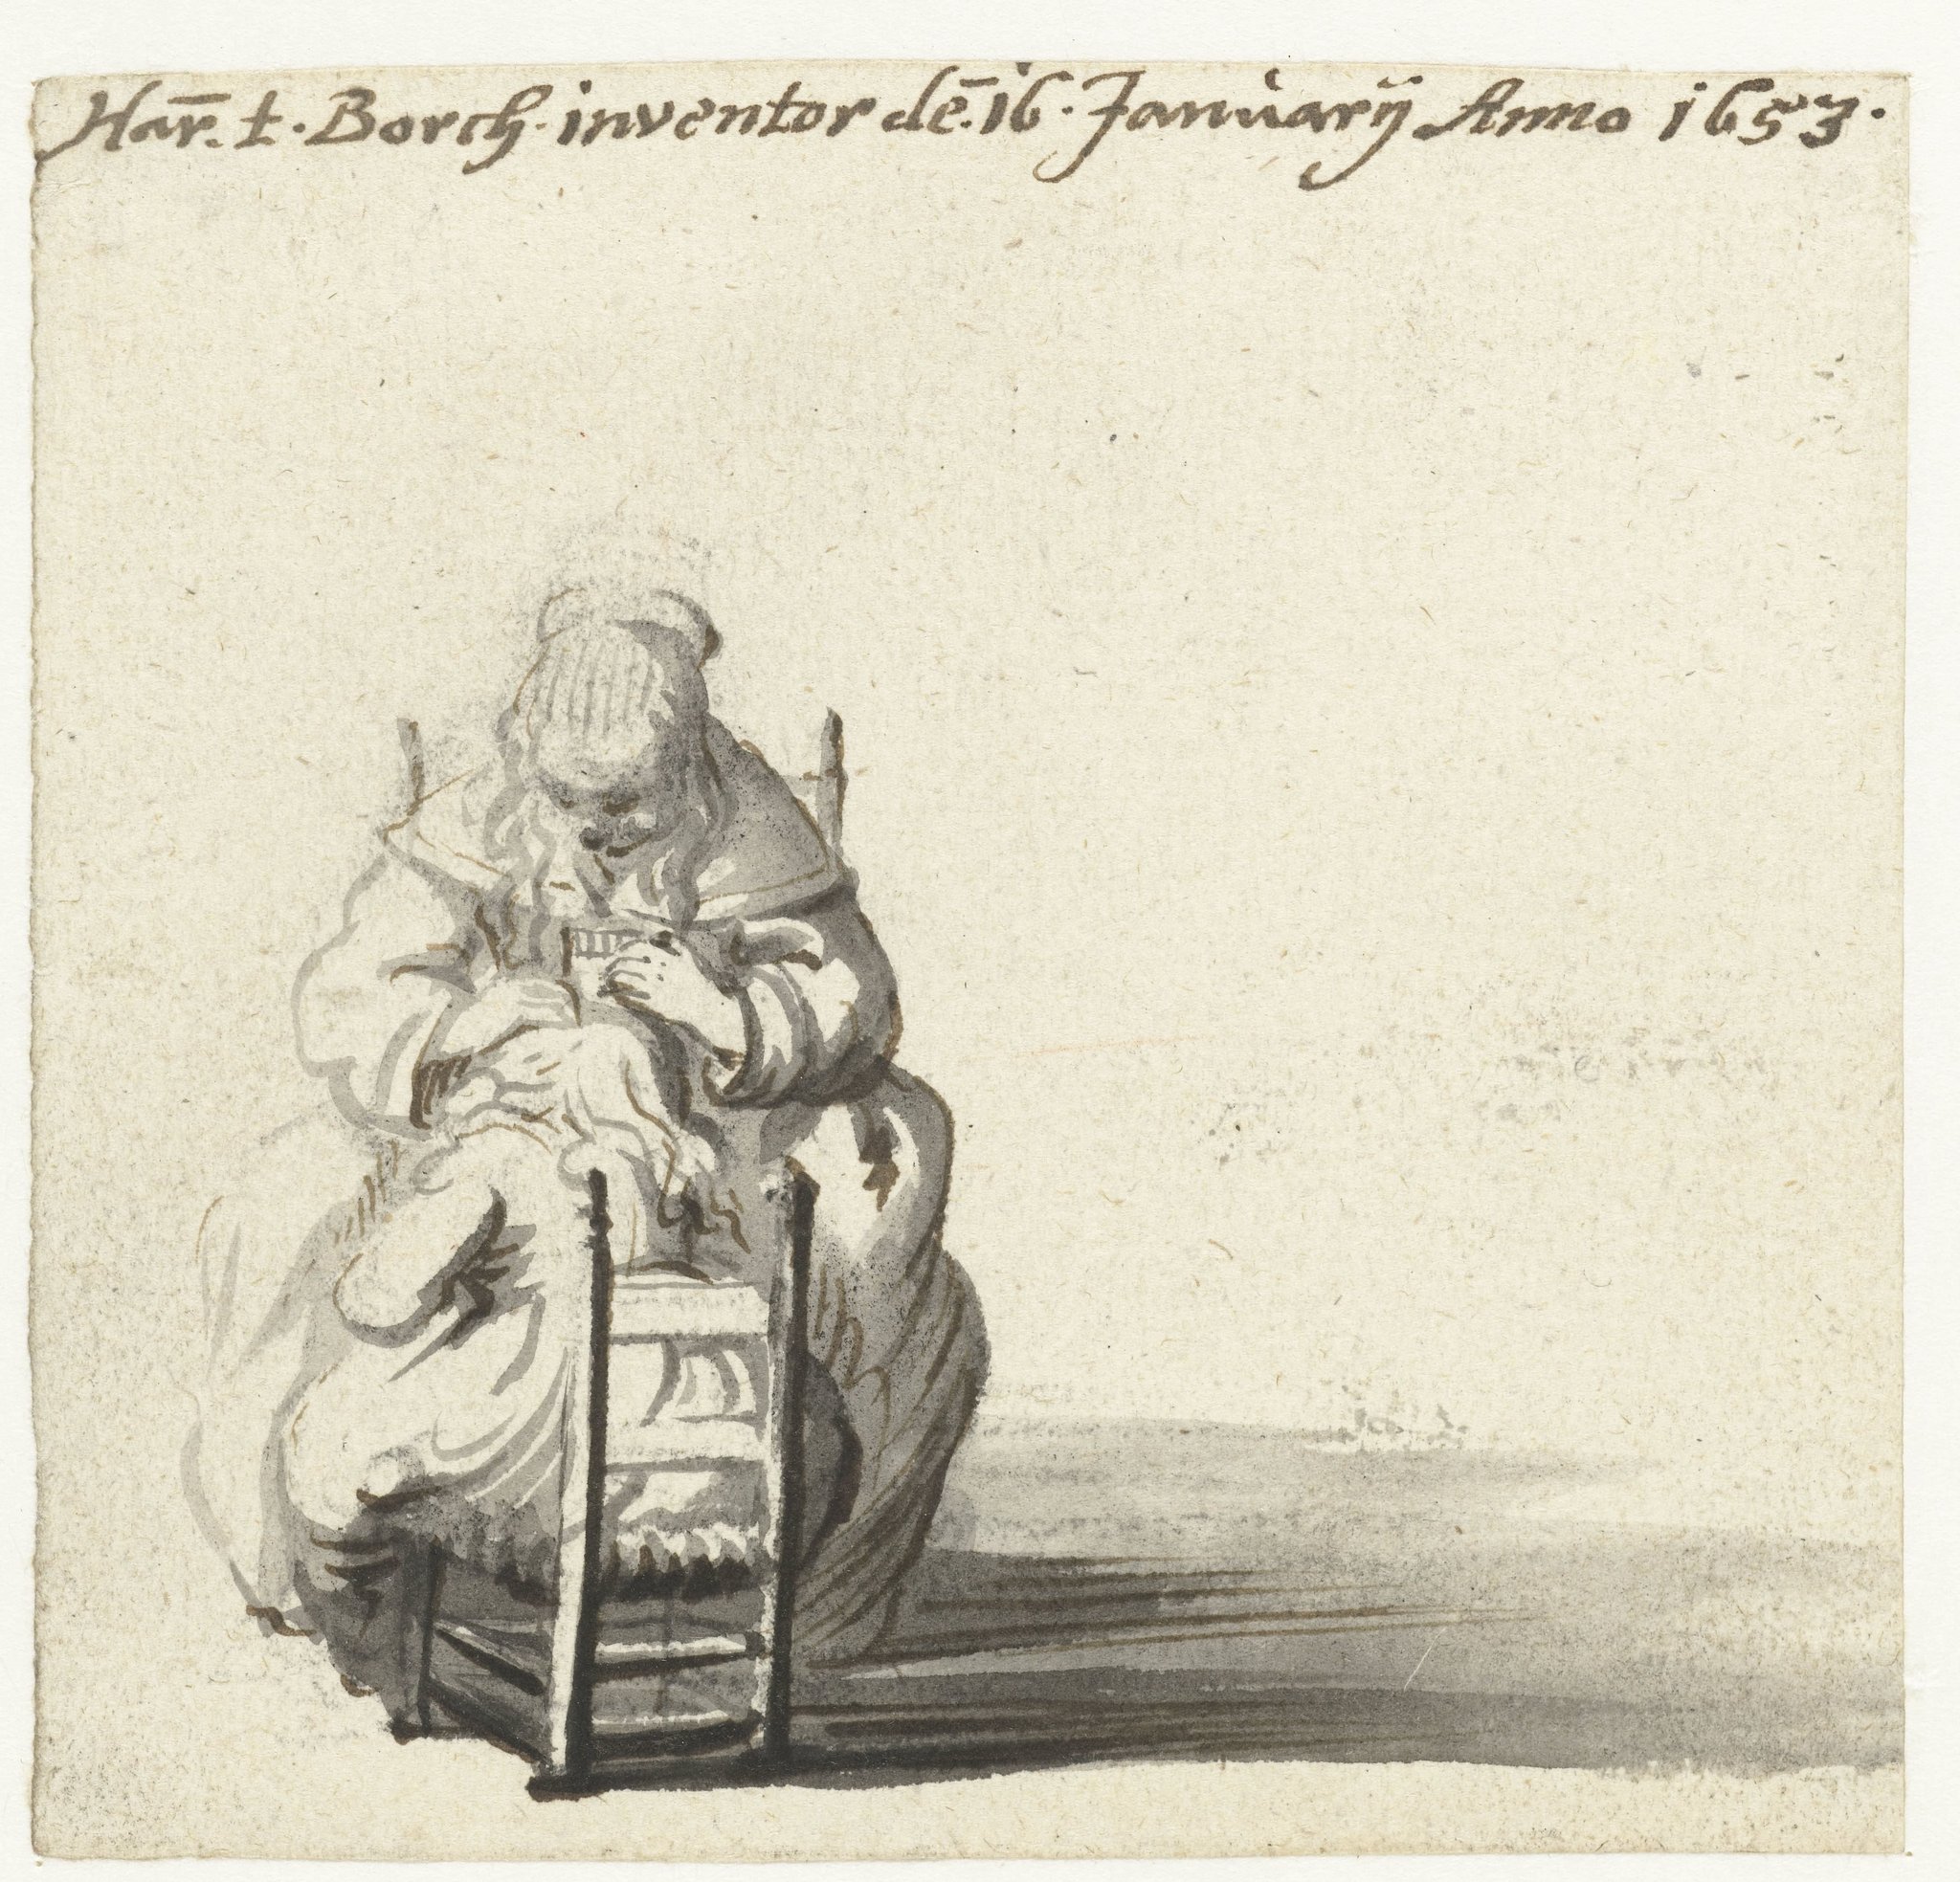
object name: drawing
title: Zittende vrouw, zoekend naar vlooien in het haar van een kind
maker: harmen ter borch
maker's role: draughtsman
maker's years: 1638-1677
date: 1653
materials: chalk, ink, paper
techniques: brush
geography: zwolle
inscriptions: annotation: ‘Har[man].t.Borch. inventor de[n].16.Januarij Anno 1653.’